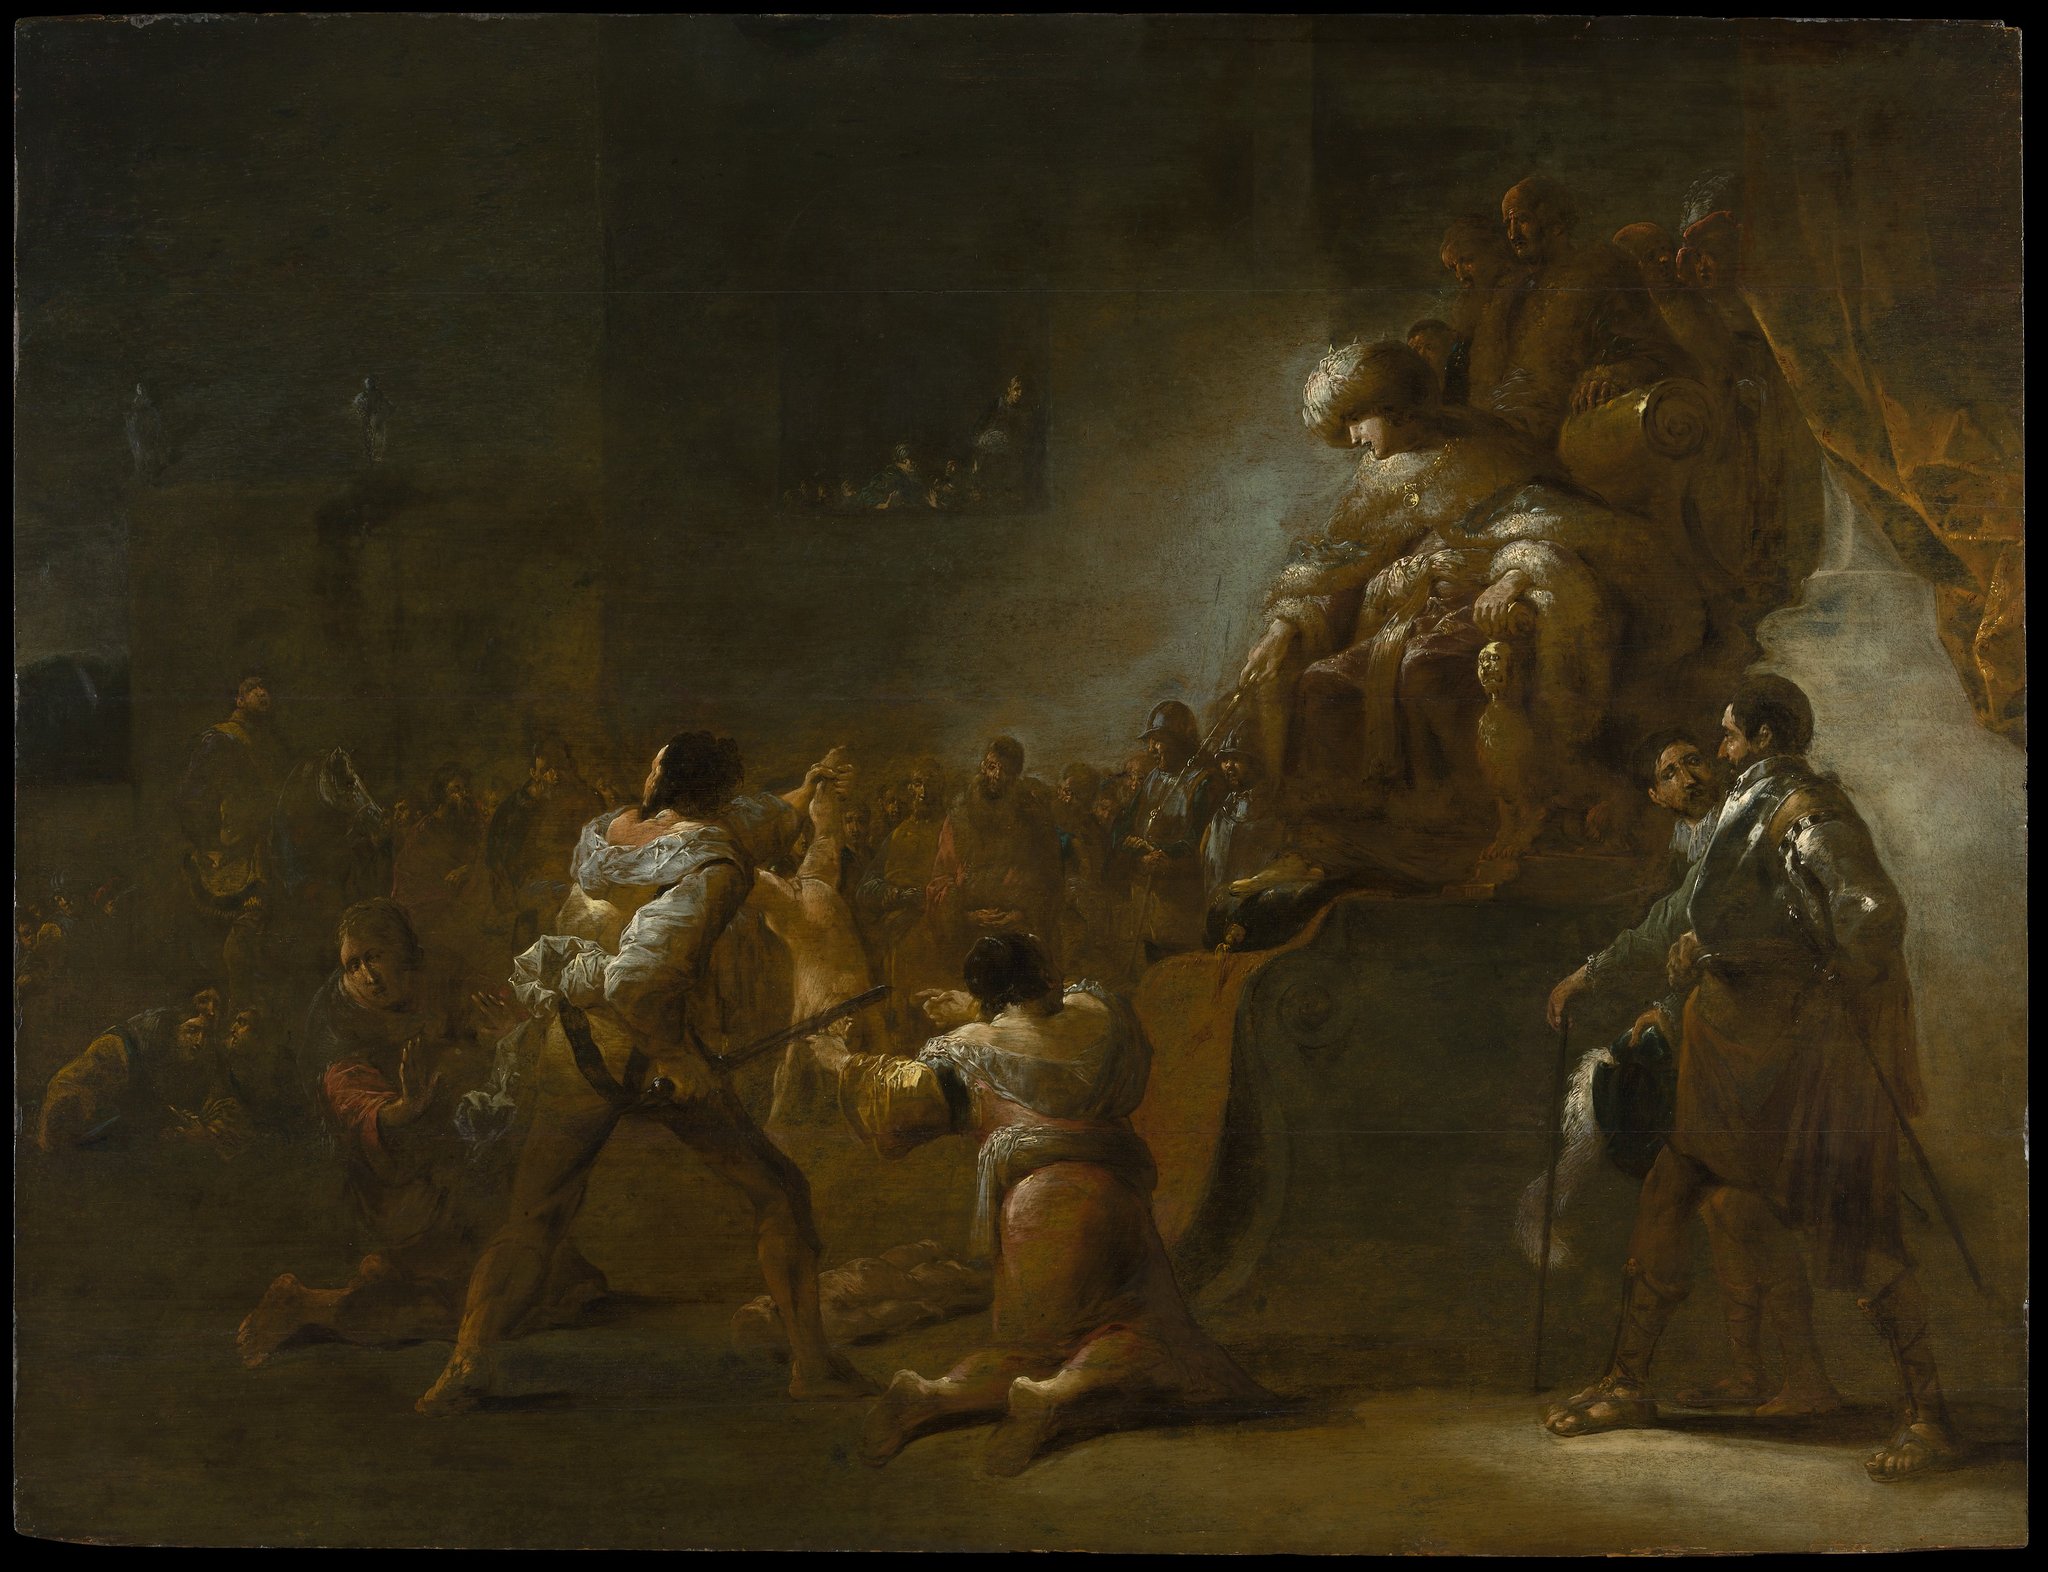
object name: painting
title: The Judgment of Solomon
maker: leonaert bramer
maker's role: artist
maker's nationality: dutch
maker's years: 1596-1674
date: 1640-1649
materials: oil, wood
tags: kings,infants,women,solomon